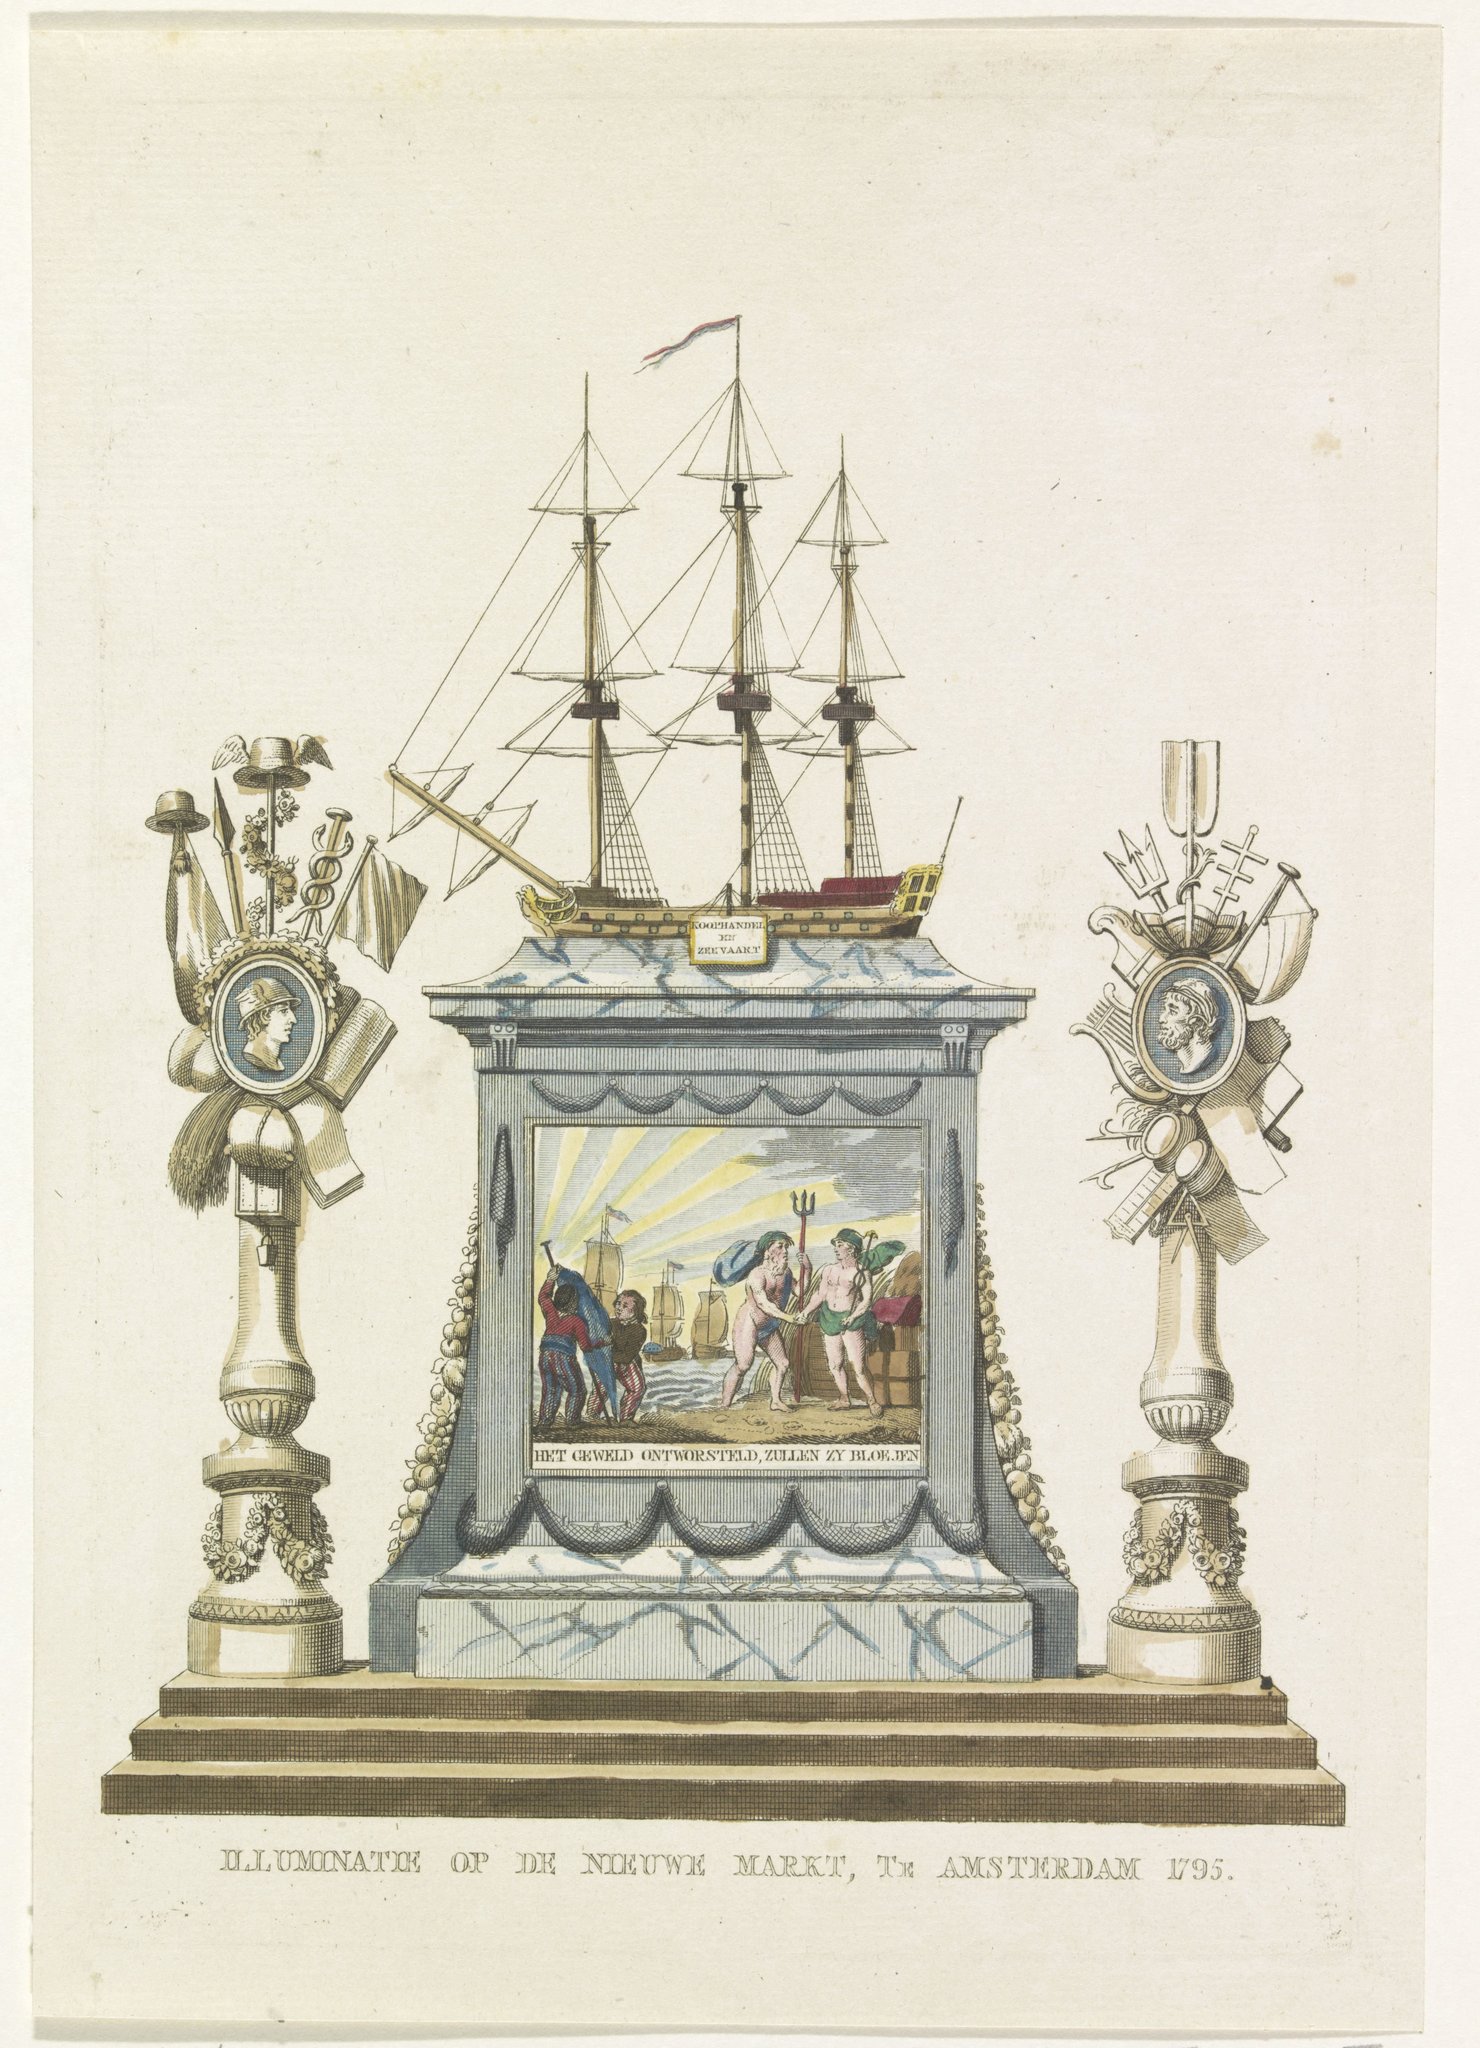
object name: print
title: Illuminatie op de Nieuwe Markt, Te Amsterdam 1795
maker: a. schol (ii)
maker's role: print maker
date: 1795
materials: paper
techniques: etching, hand coloring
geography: netherlands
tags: ship-model (+ propulsion of vehicle, ship, etc. by wind), festivities on events of national importance (+ festive decoration ~ festive activities), amsterdam, alliance with france (1795)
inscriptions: collector's mark: Lugt 2228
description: Koophandel en Zeevaart, allegorische decoratie opgericht in de Nieuwmarkt te Amsterdam bij het Alliantiefeest op 19 juni 1795. Reusachtig model van een koopvaardijschip op een voetstuk met chassinet met voorstelling van Neptunus en Mercurius die elkaar de hand schuppen terwijl de Franse en Bataafse matroos de Britse vlag aan stukken scheuren. Onderdeel van een serie van dertien platen.